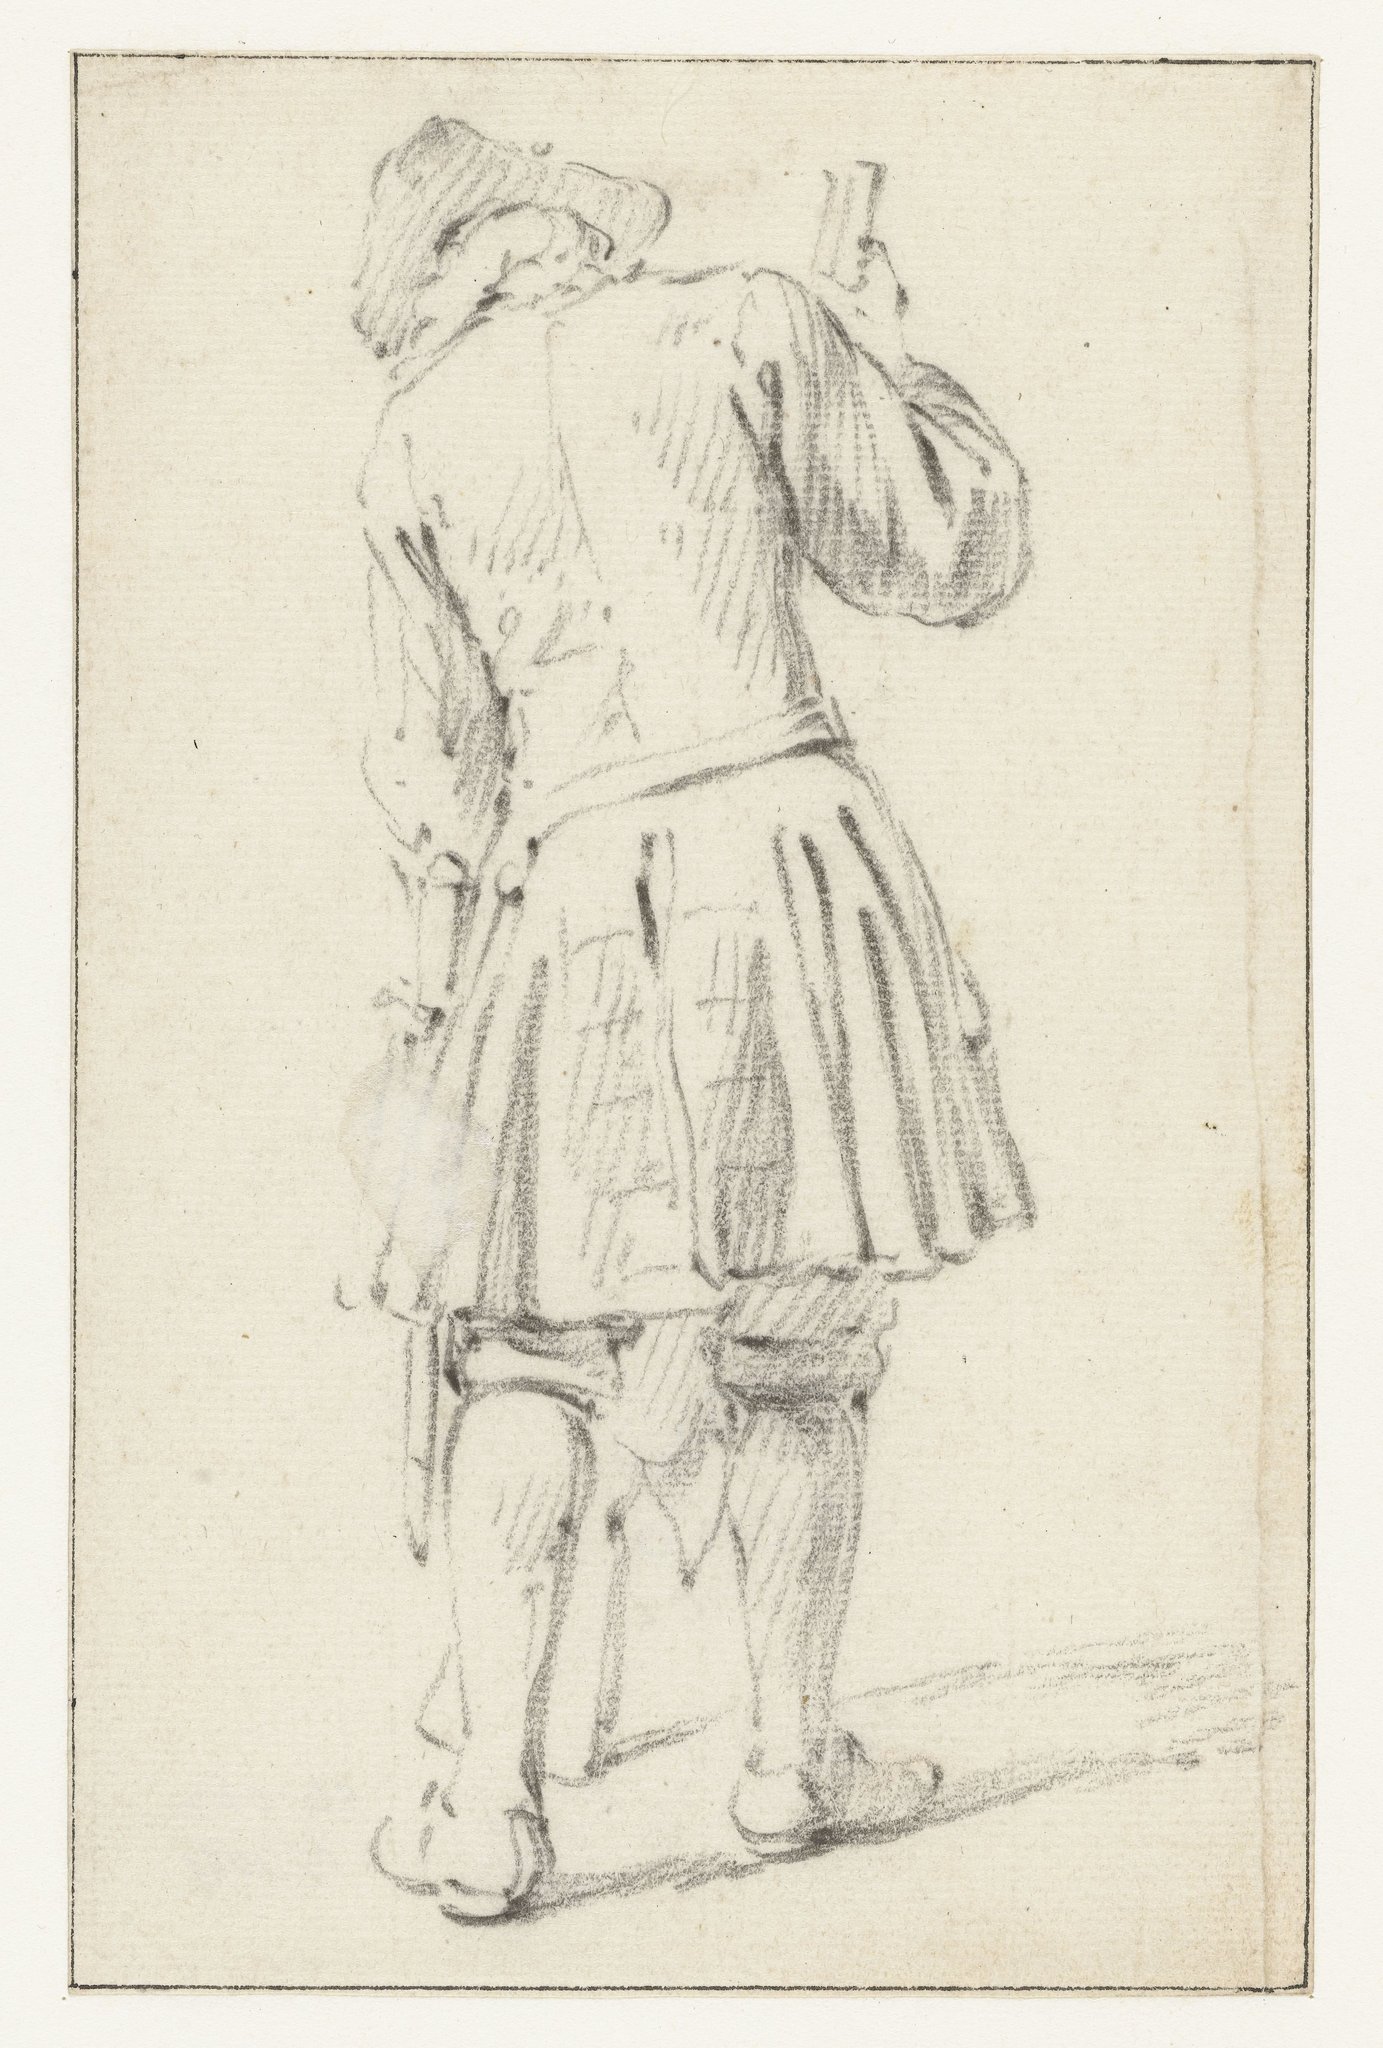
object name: drawing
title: Standing Soldier with a Rifle, Seen from Behind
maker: dirk maas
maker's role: draughtsman, print maker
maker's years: 1659-1717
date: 1690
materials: chalk, paper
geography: england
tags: the soldier; the soldier's life, male sex; man (+ back view)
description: Staande soldaat die een geweer vasthoudt dat met de kolf op de grond staat.